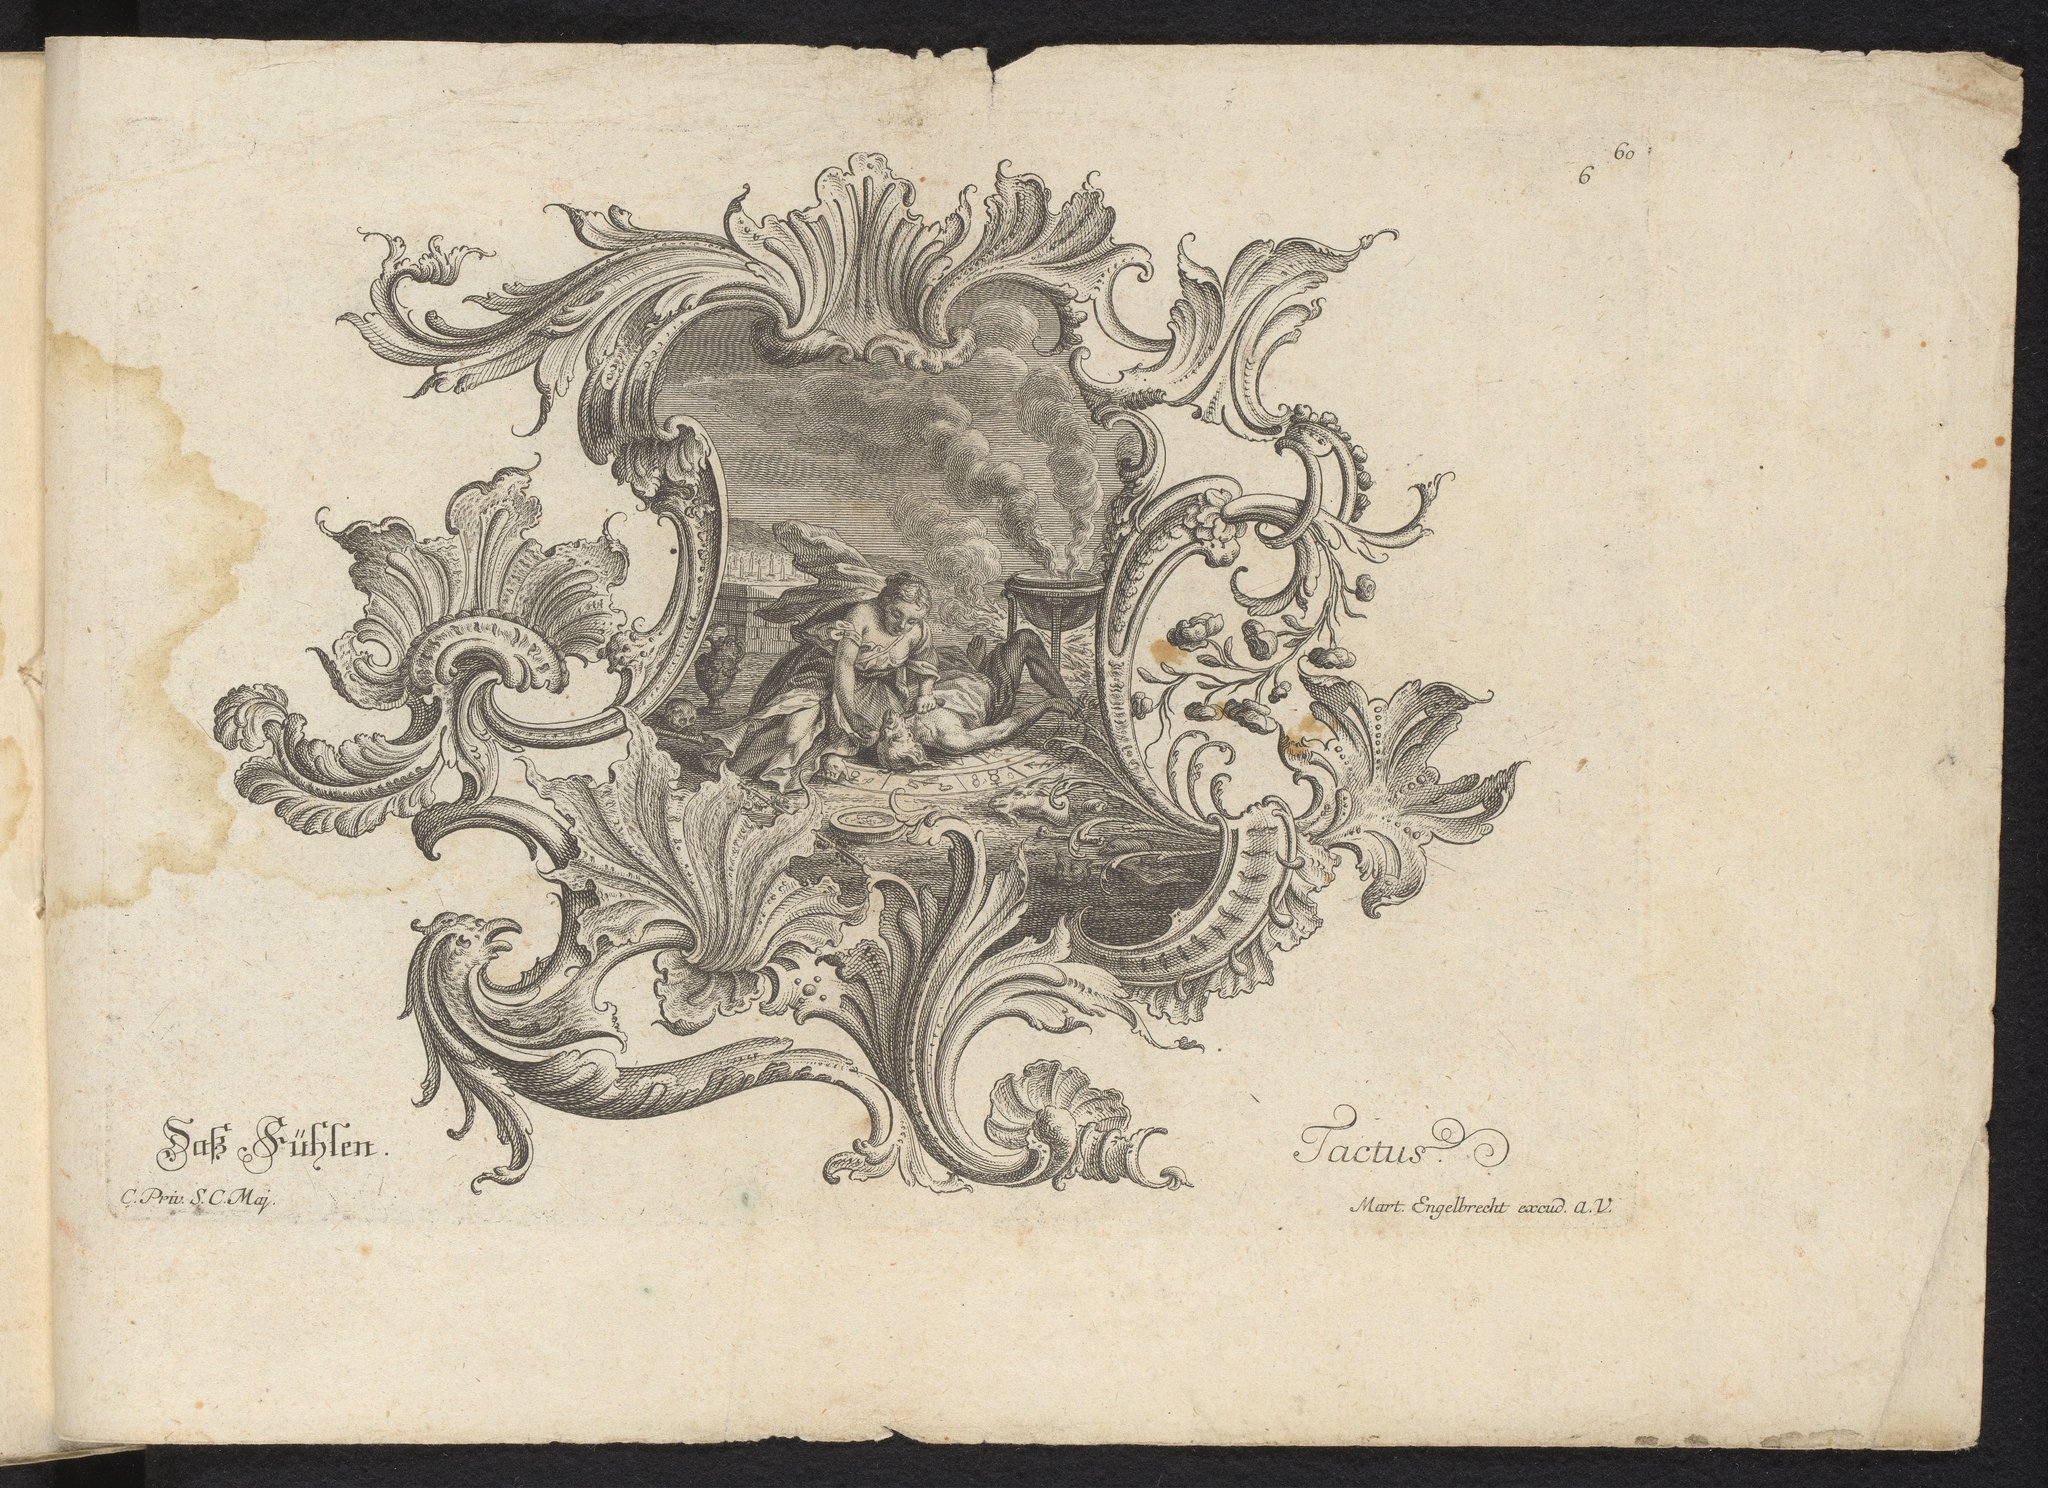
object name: print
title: Das Fühlen / Tactus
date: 1712-1755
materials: paper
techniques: etching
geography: augsburg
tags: human sacrifice ~ non-christian religions, aeson's throat is cut, his old blood runs out, his veins are filled with medea's brew, and he is rejuvenated, witch, sorceress, feeling (one of the five senses), ornament ~ cartouche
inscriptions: collector's mark: Lugt 2228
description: Rocaille cartouche met een scène van een offering van een oude man in de buitenlucht. Hij ligt op een cirkel, zijn keel wordt doorgesneden door een vrouw, waarschijnlijk een heks of tovenares. Rondom hen liggen een geitenkop, een doodshoofd, een vaas en rechts in de achtergrond staat een kookpot. Mogelijk het verhaal van Medea en de verjonging van Aeson. Prentnummer 60.